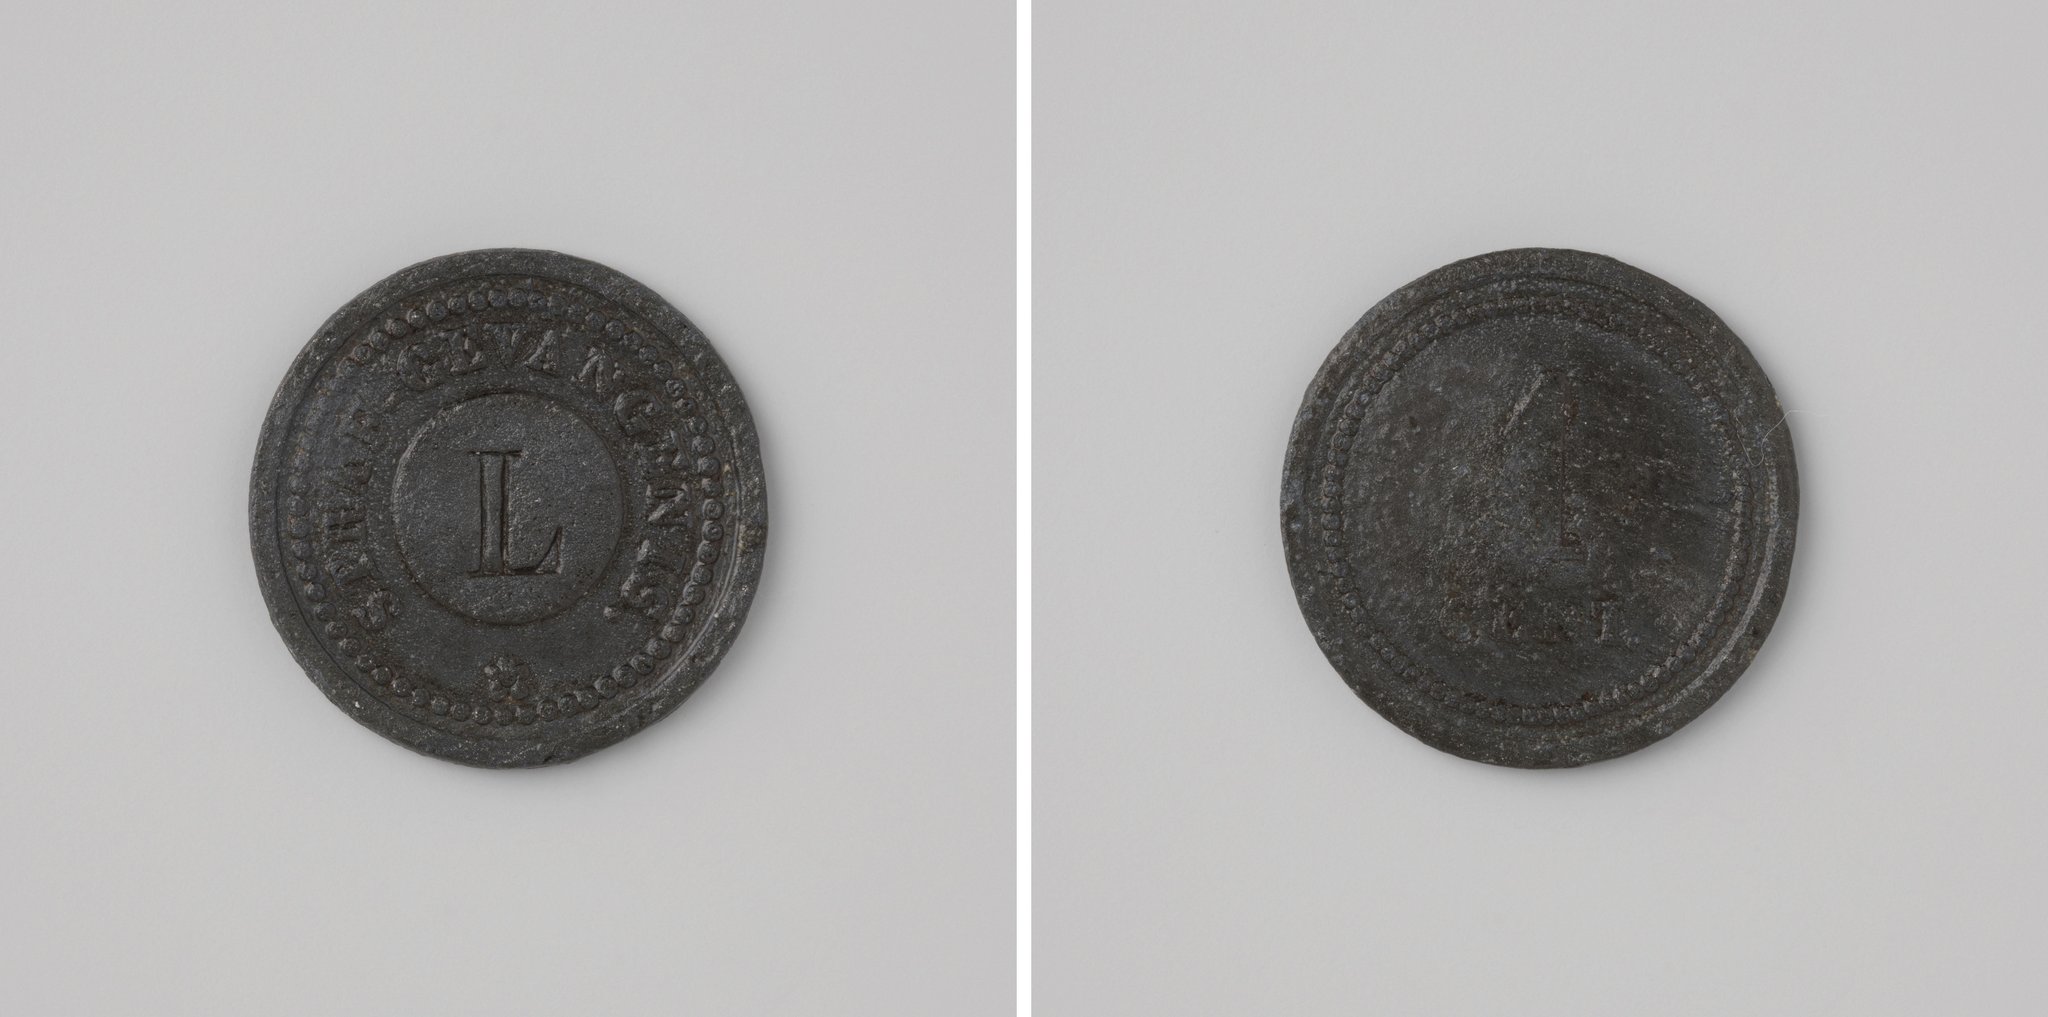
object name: monetary token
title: Strafgevangenis te Leiden, huismunt ter waarde van een cent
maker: Anonymous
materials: zinc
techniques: striking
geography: utrecht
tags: leiden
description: Zinken betaalpenning. Voorzijde: letter L binnen omschrift. Keerzijde: waardeaanduiding